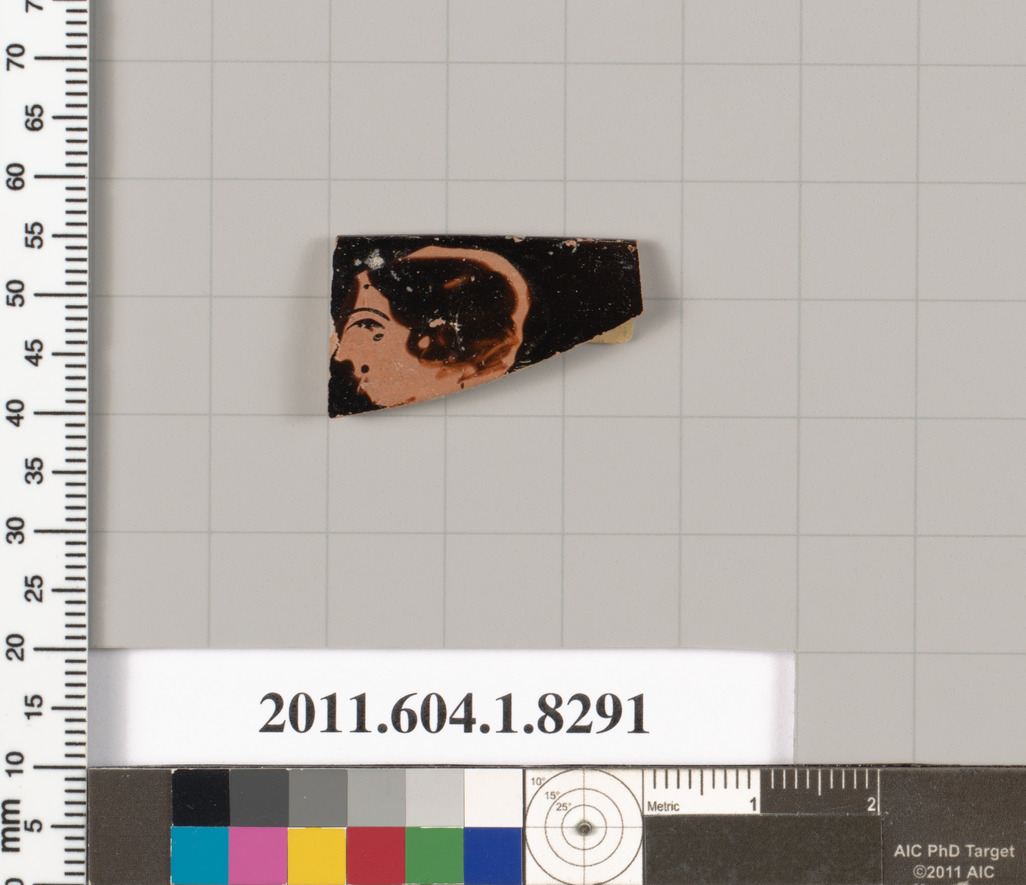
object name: kylix fragment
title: Terracotta rim fragment of a kylix (drinking cup)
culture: greek, attic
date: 400-376 BCE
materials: terracotta